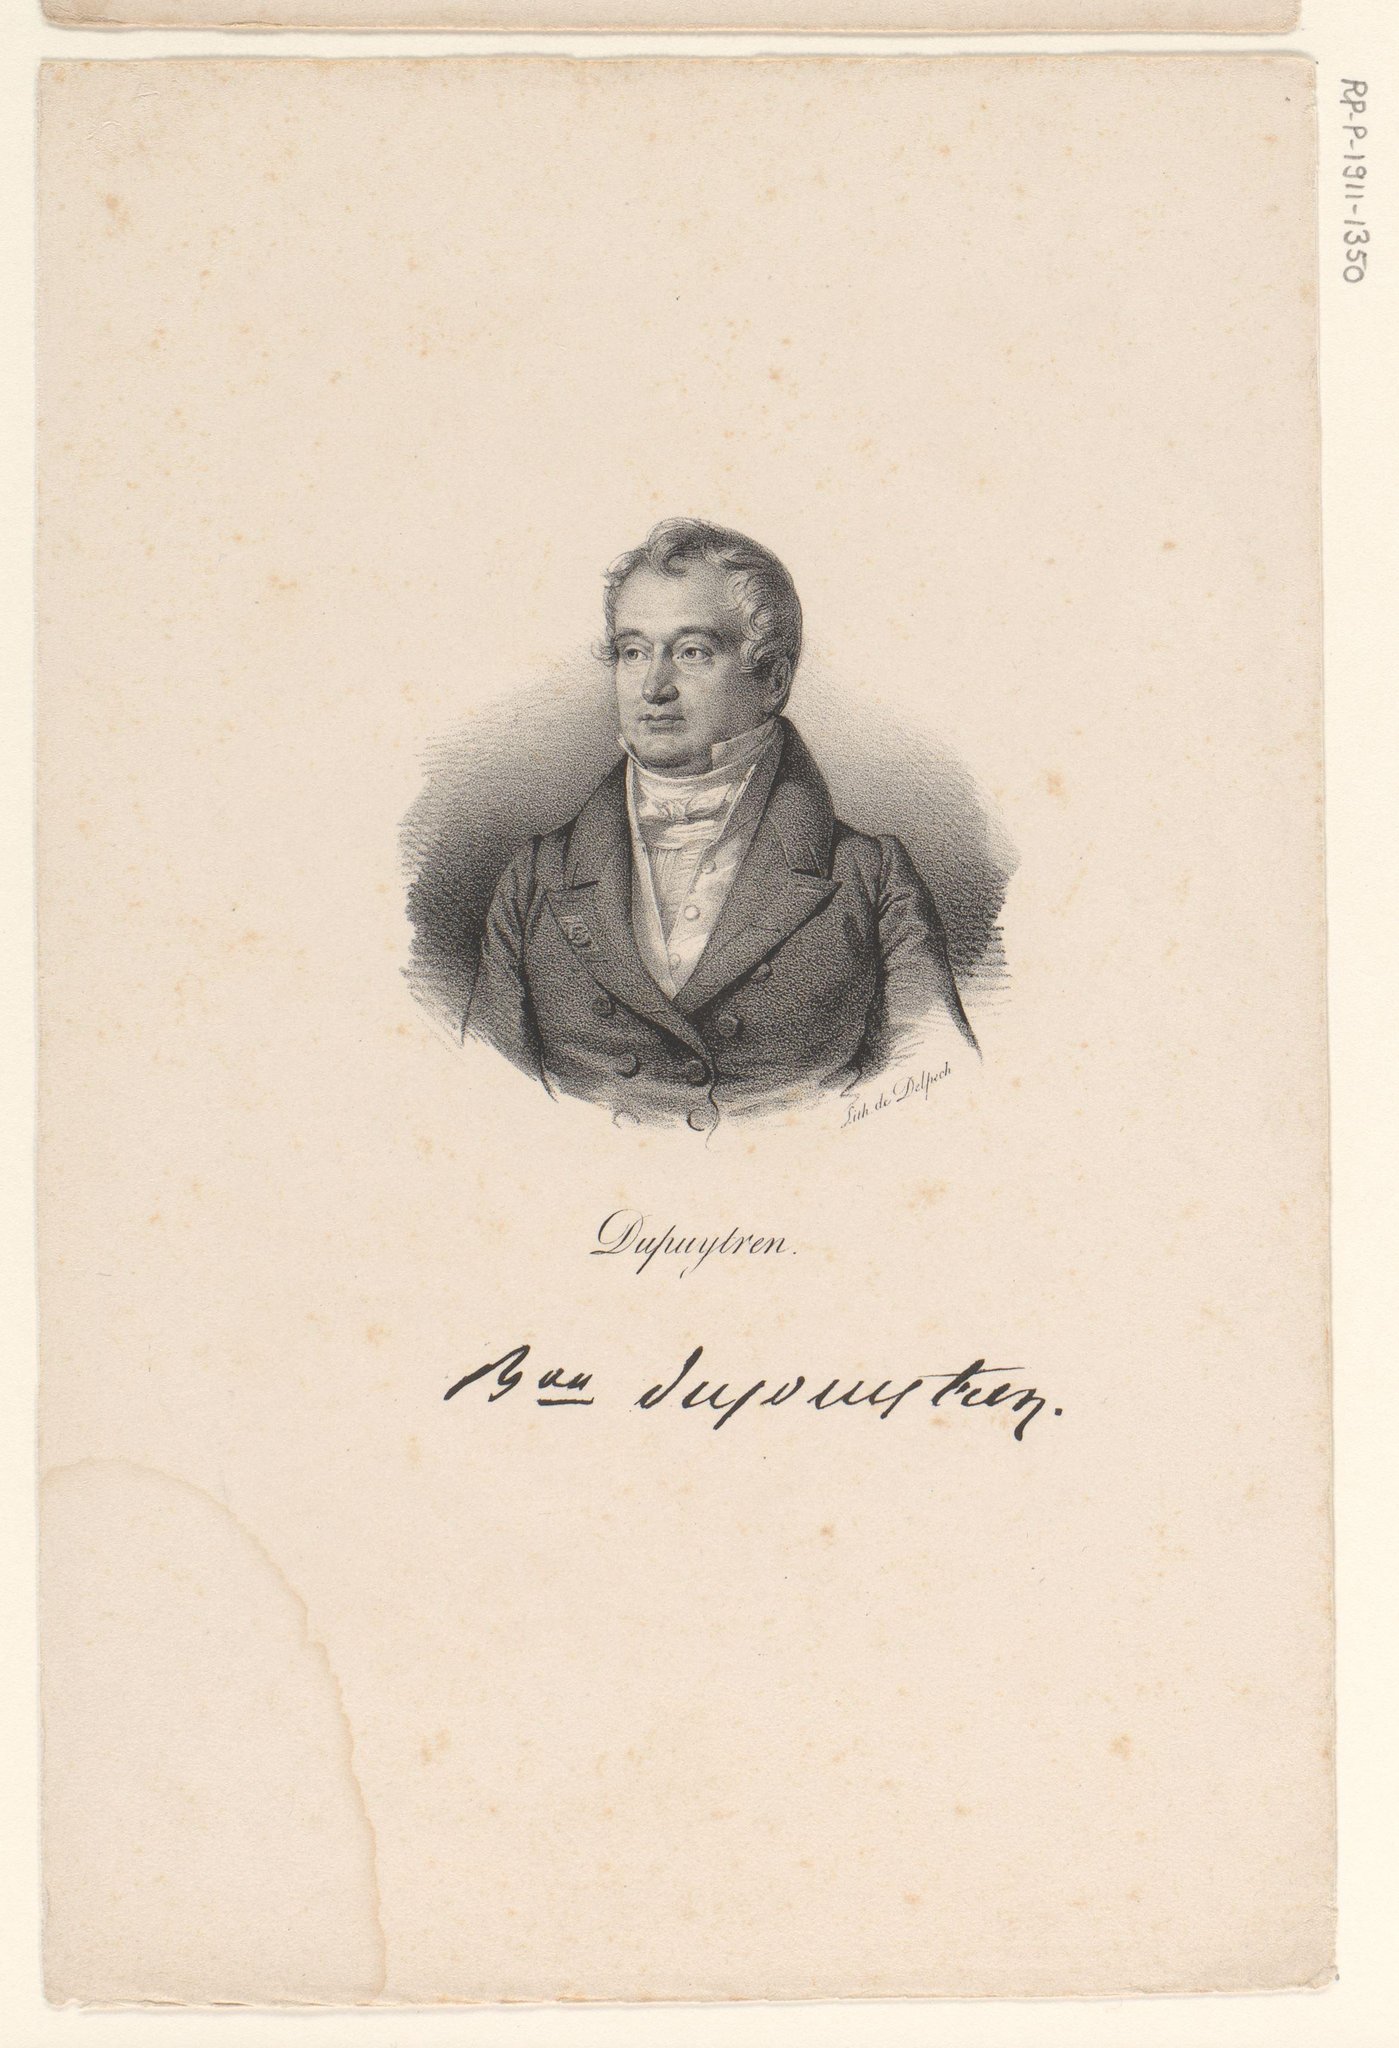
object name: print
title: Portret van Guillaume Dupuytren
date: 1818-1842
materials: paper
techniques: lithograph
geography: paris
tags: historical persons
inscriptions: collector's mark: Lugt 2228a